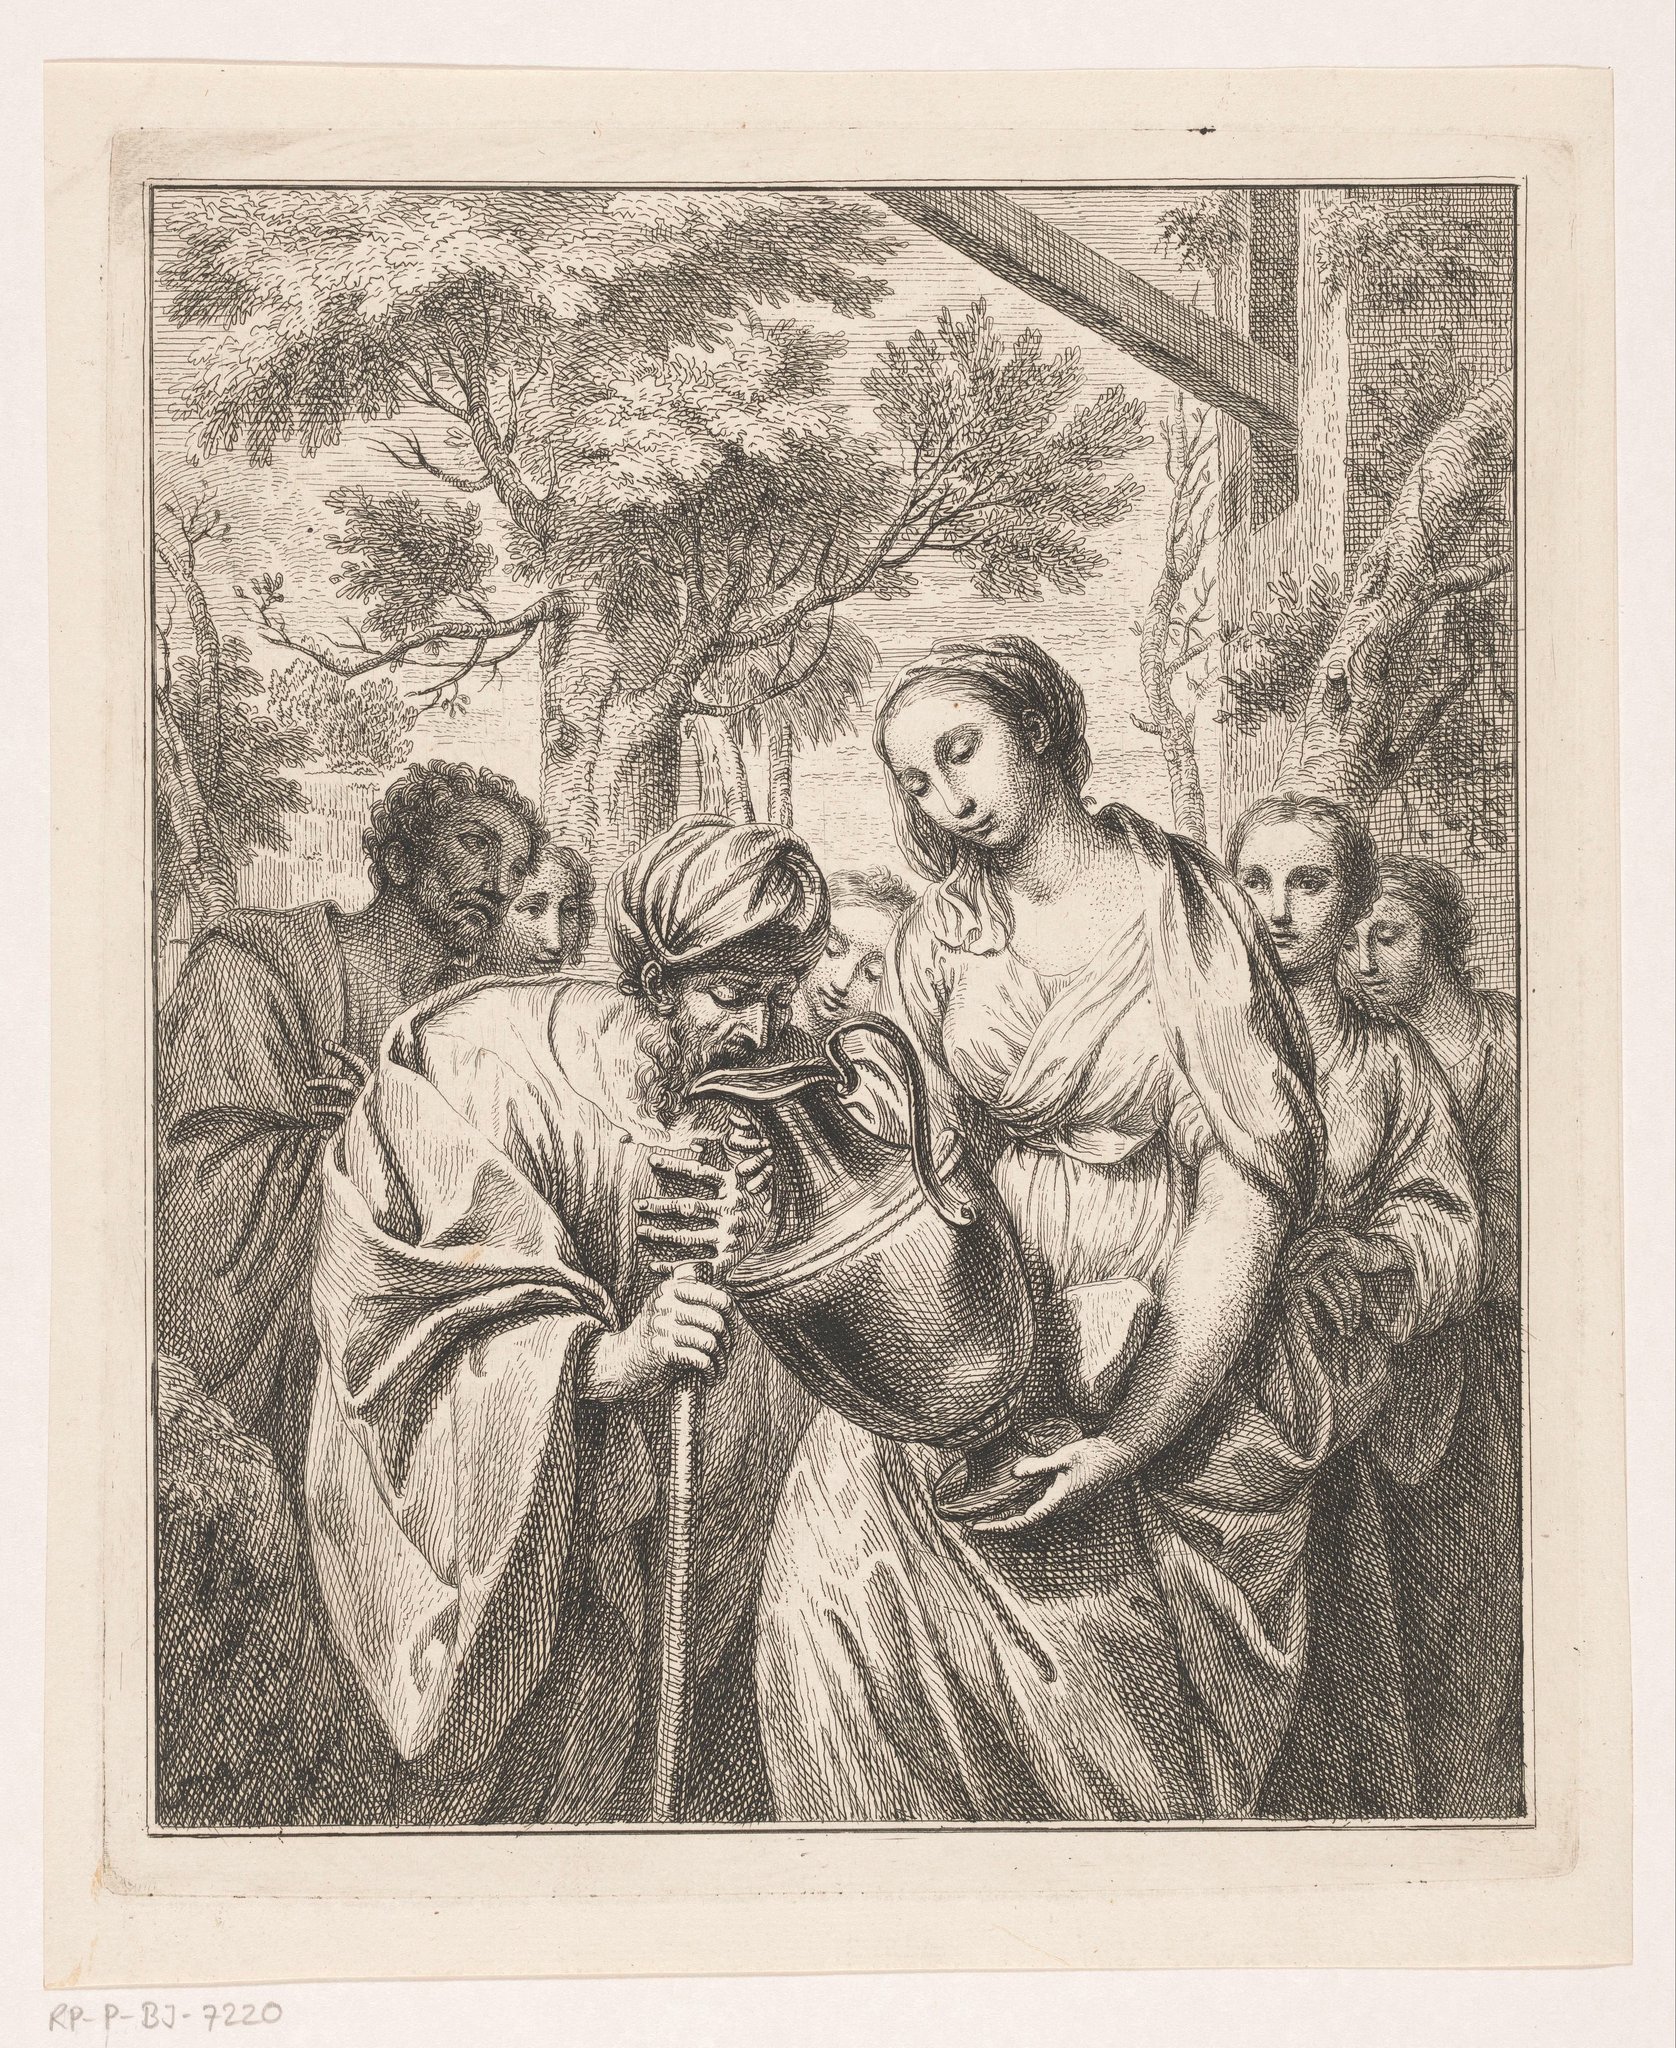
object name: print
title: Rebekka en Eliëzer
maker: louis fabritius dubourg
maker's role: draughtsman, print maker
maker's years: 1693-1775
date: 1713-1775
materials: paper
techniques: etching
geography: amsterdam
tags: the meeting at the well: eliezer sees rebekah coming with a pitcher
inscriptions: collector's mark: Lugt 240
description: Rebekka geeft Eliëzer te drinken uit een kan. Achter hen vier vrouwen en een man.